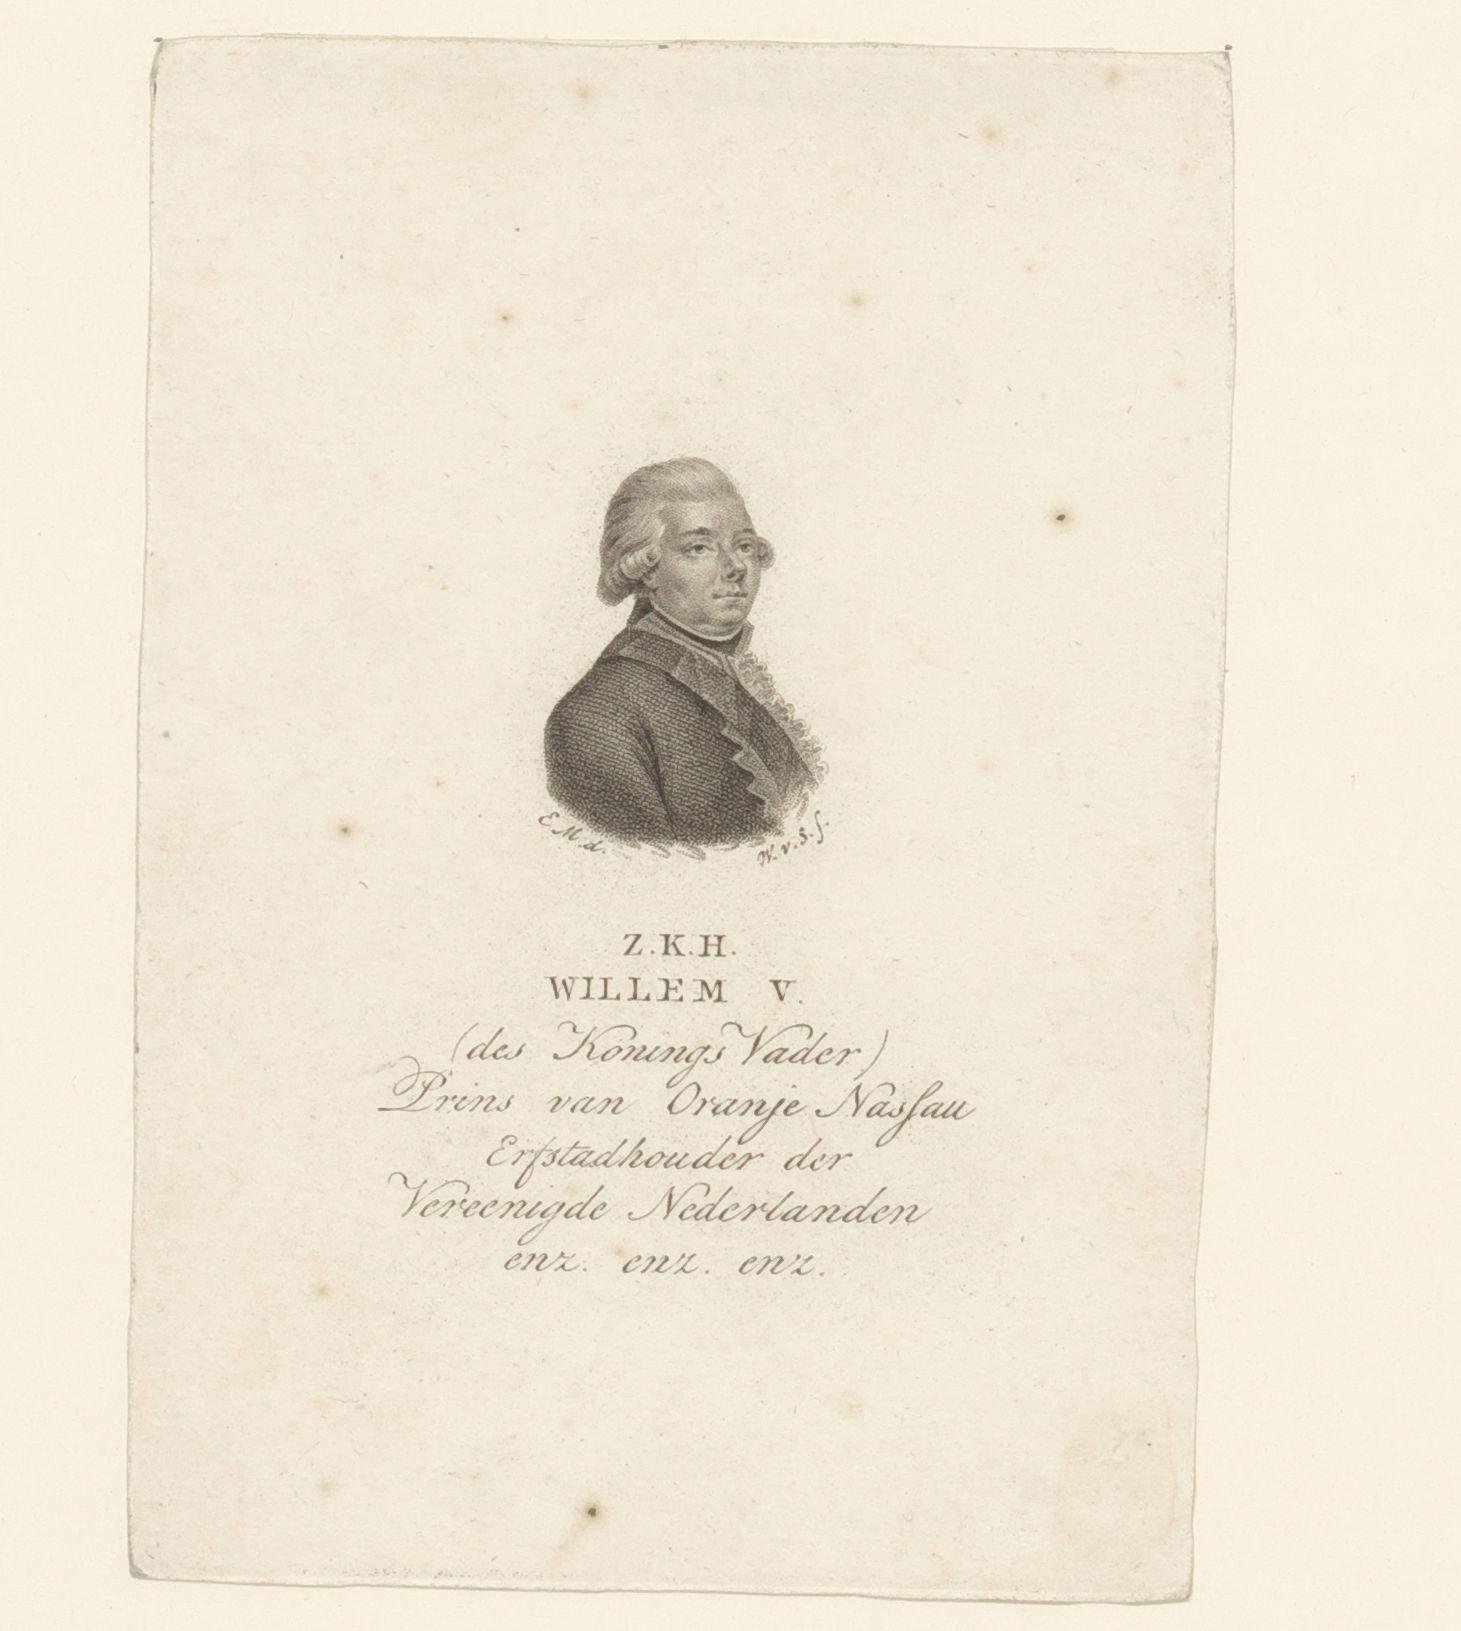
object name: print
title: Z.K.H. Willem V (des Konings Vader) Prins van Oranje Nassau Erfstadhouder der Vereenigde Nederlanden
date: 1787-1851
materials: paper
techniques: engraving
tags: the hague, william v (prince of orange), historical persons, king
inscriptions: stamp, collector's mark: Lugt 1641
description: Portret van Willem V. In de ondermarge zijn naam en titels. Onderwerpsrubrieken binnen de Atlas Zeden en Gewoonten: Portretten, Portretten van Vorsten uit het huis van Oranje, Regeerende Vorsten, Stadhouders van Holland, Zeeland en West-Friesland.